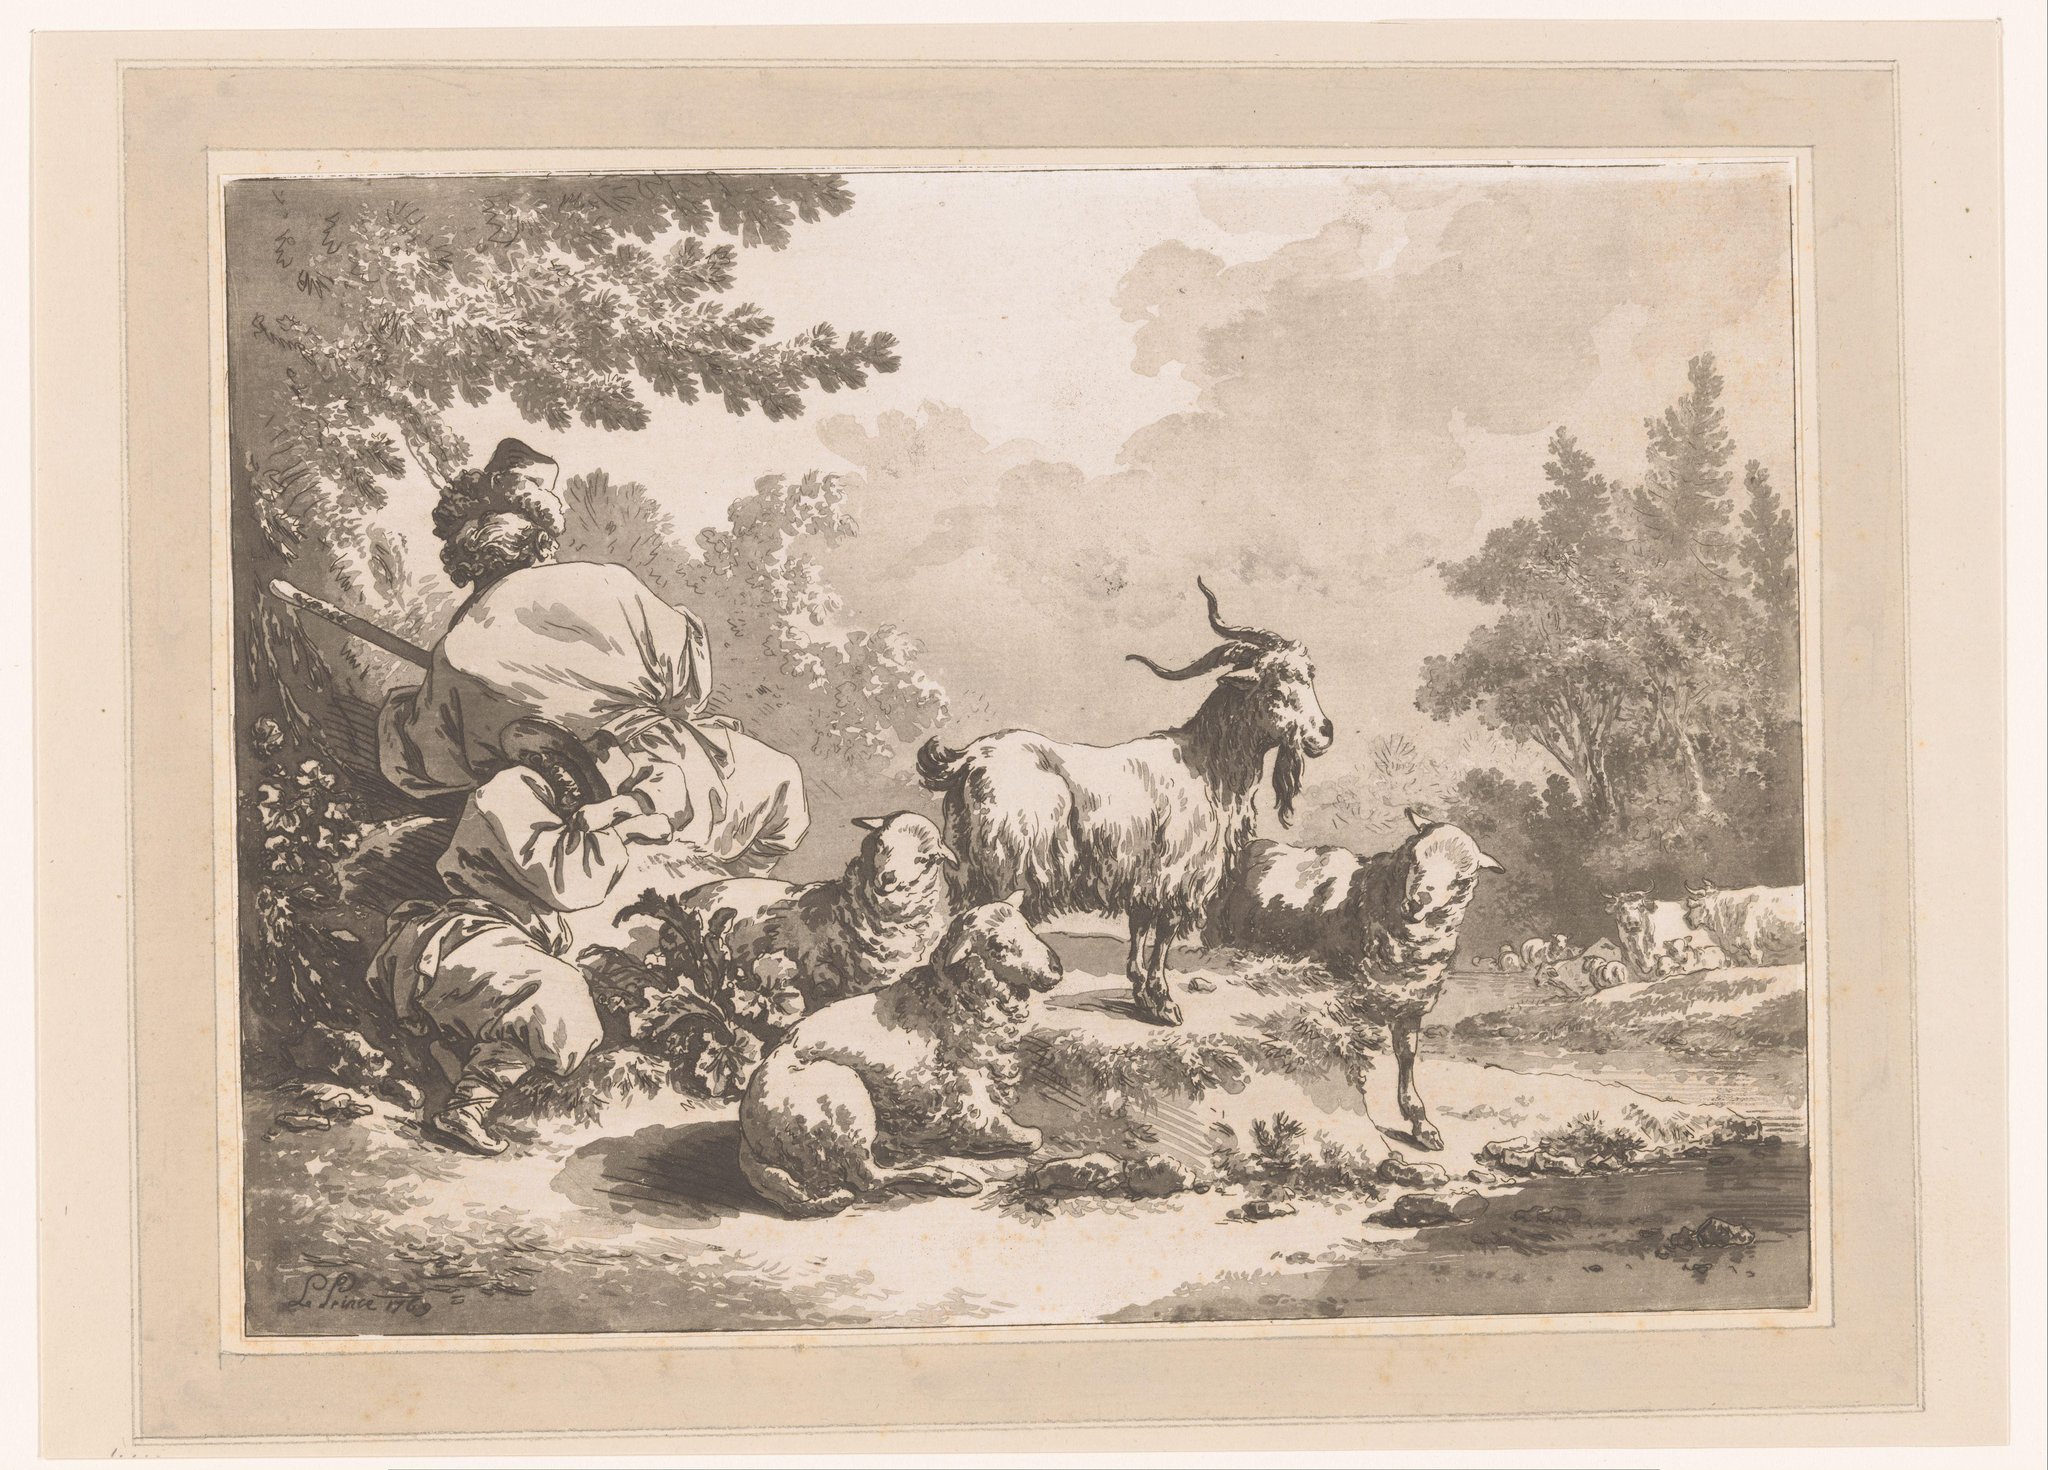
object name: print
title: Twee rustende herders met schapen onder een boom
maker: jean baptist leprince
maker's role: draughtsman, print maker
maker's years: 1734-1781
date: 1769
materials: paper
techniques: aquatint, etching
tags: herding, herdsman, herdswoman, shepherd, shepherdess, cowherd, etc., sheep, resting - bb - out of doors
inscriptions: date